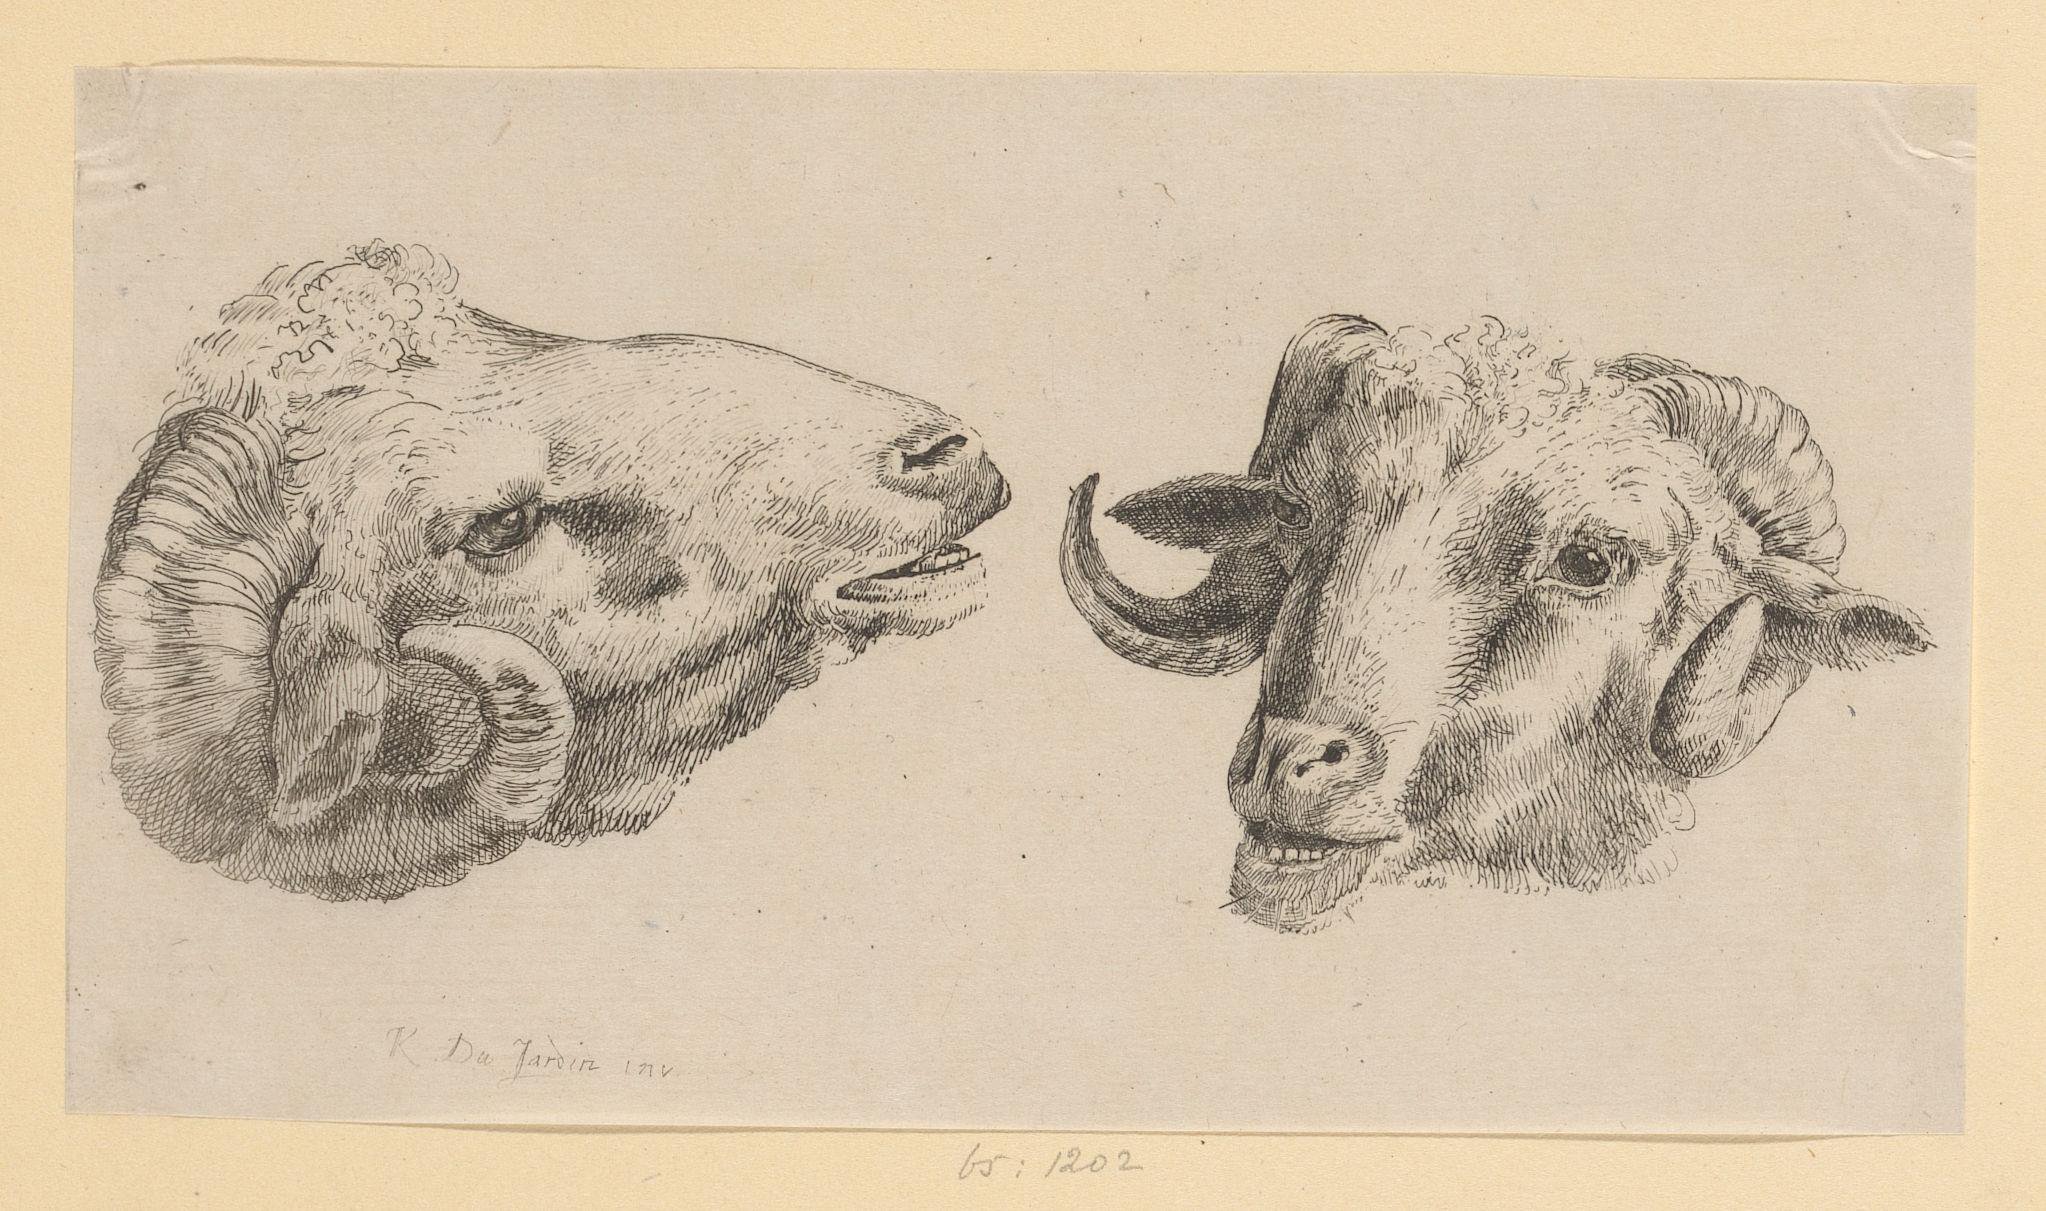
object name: print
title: Twee ramskoppen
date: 1805-1844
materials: paper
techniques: etching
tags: ram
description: Prent maakt deel uit van een serie van 11 prenten. Prent maakt mogelijk deel uit van een serie van 200 prenten. Deze serie is onder de titel 'A Collection of two hundred original etchings' voor het eerst uitgegeven door J.M. Greery in 1816.